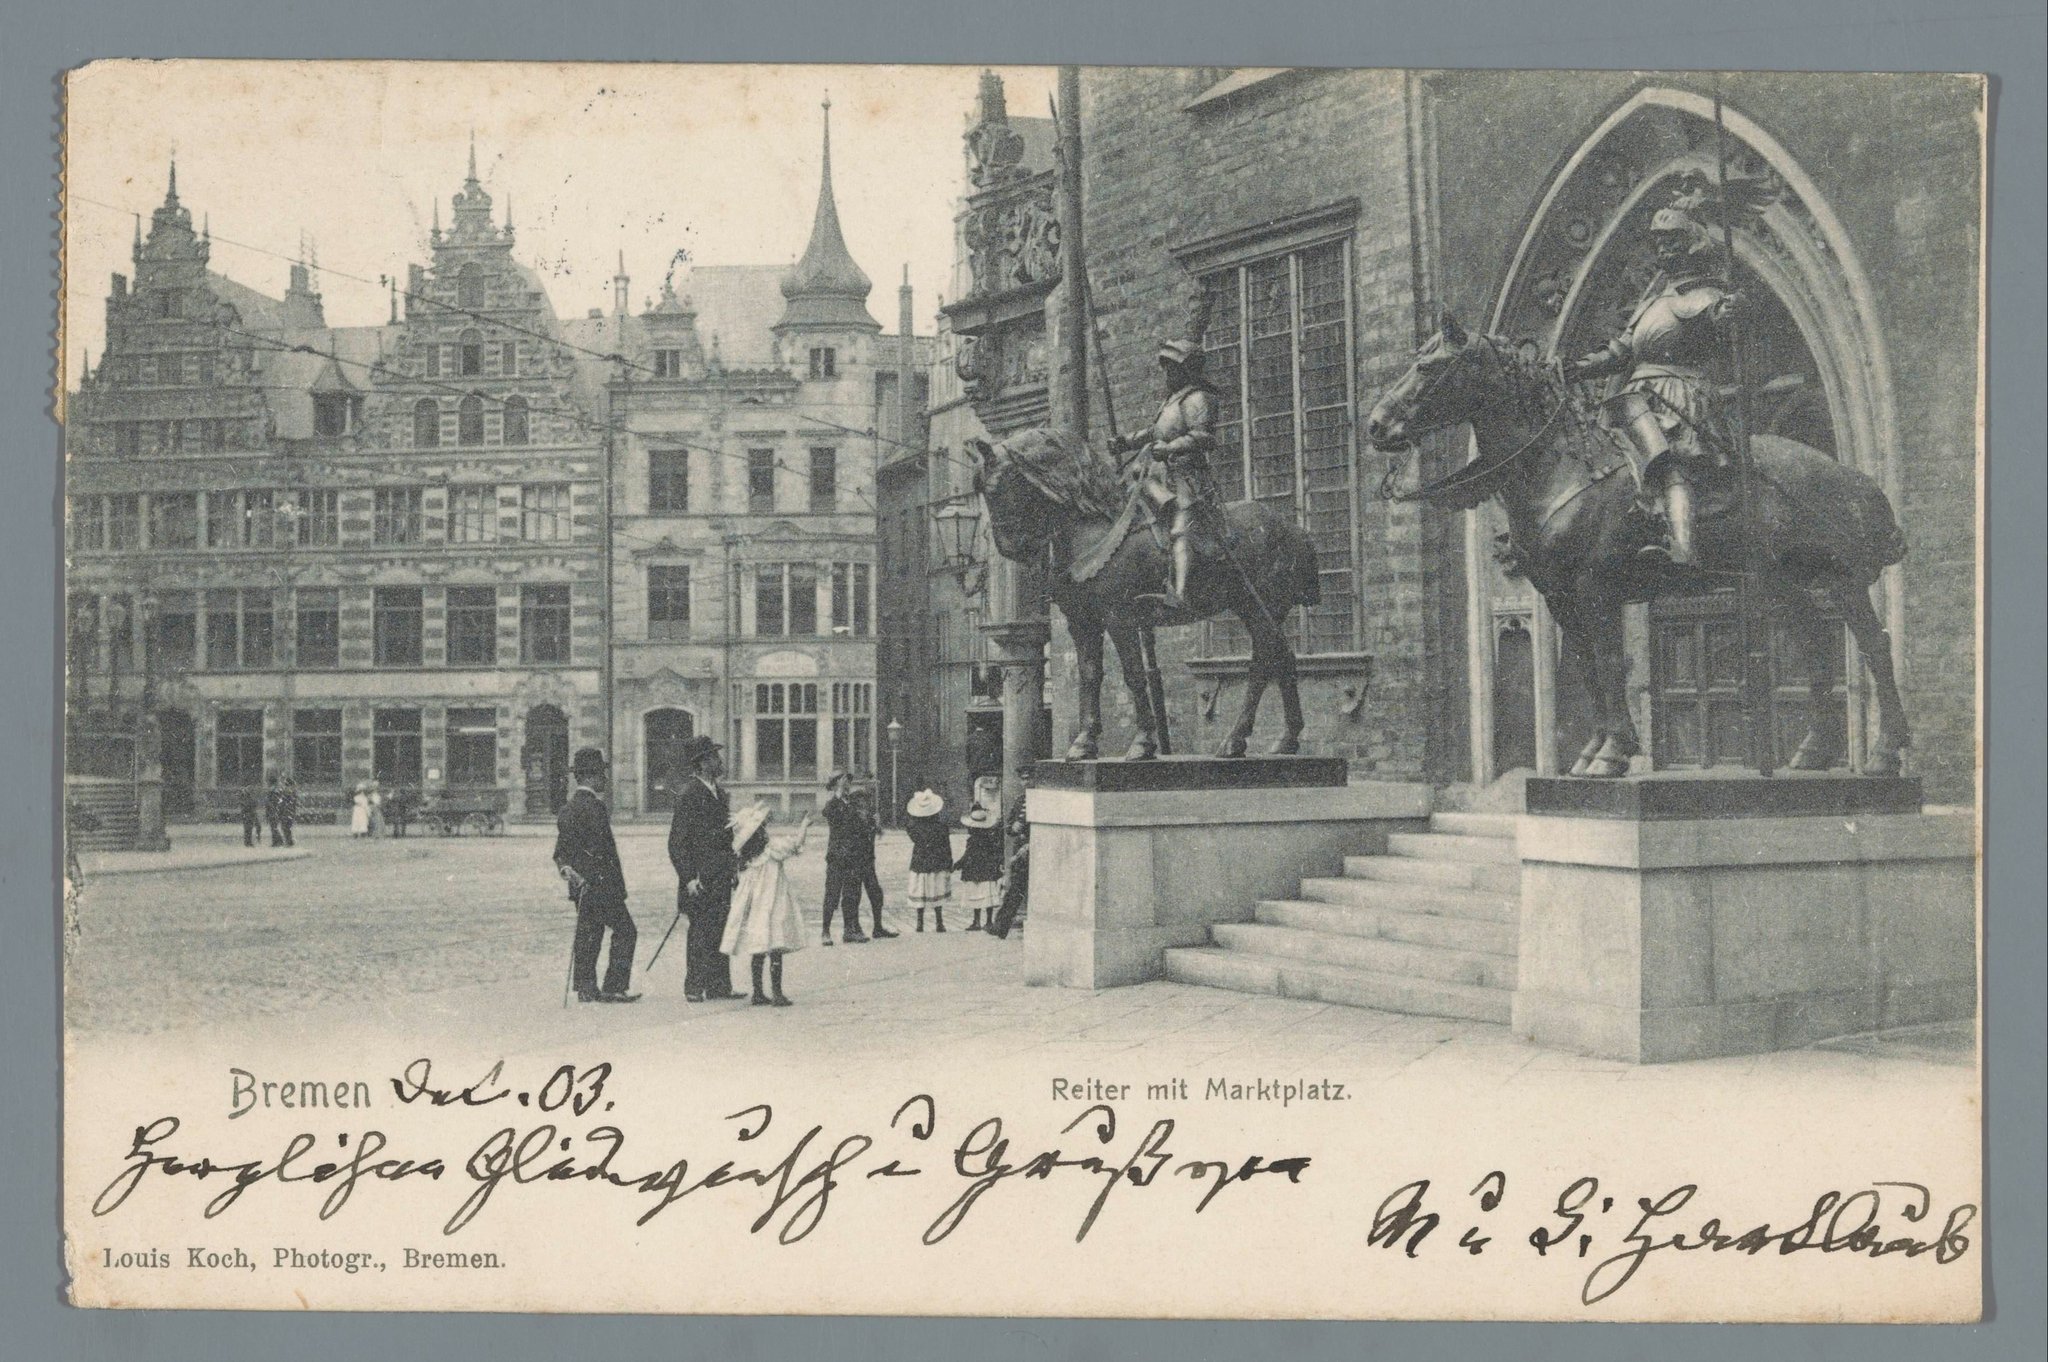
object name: photomechanical print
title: Bremen, Reiter mit Marktplatz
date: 1904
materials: paper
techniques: photograph, writing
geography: bremen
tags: square, place, circus, etc., monument, statue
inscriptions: annotation: ‘Jul. 03/ [...]’